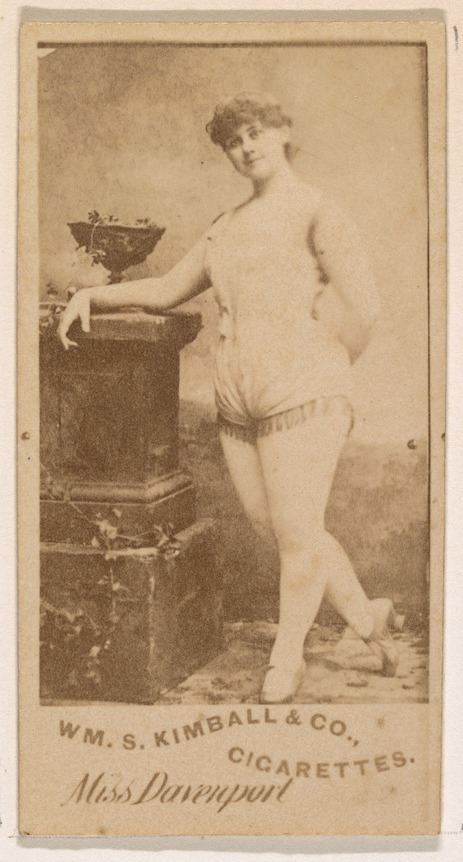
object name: photograph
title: Miss Davenport, from the Actresses series (N203) issued by Wm. S. Kimball & Co.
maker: william s. kimball & company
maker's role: publisher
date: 1889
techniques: color lithograph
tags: portraits,women,actresses